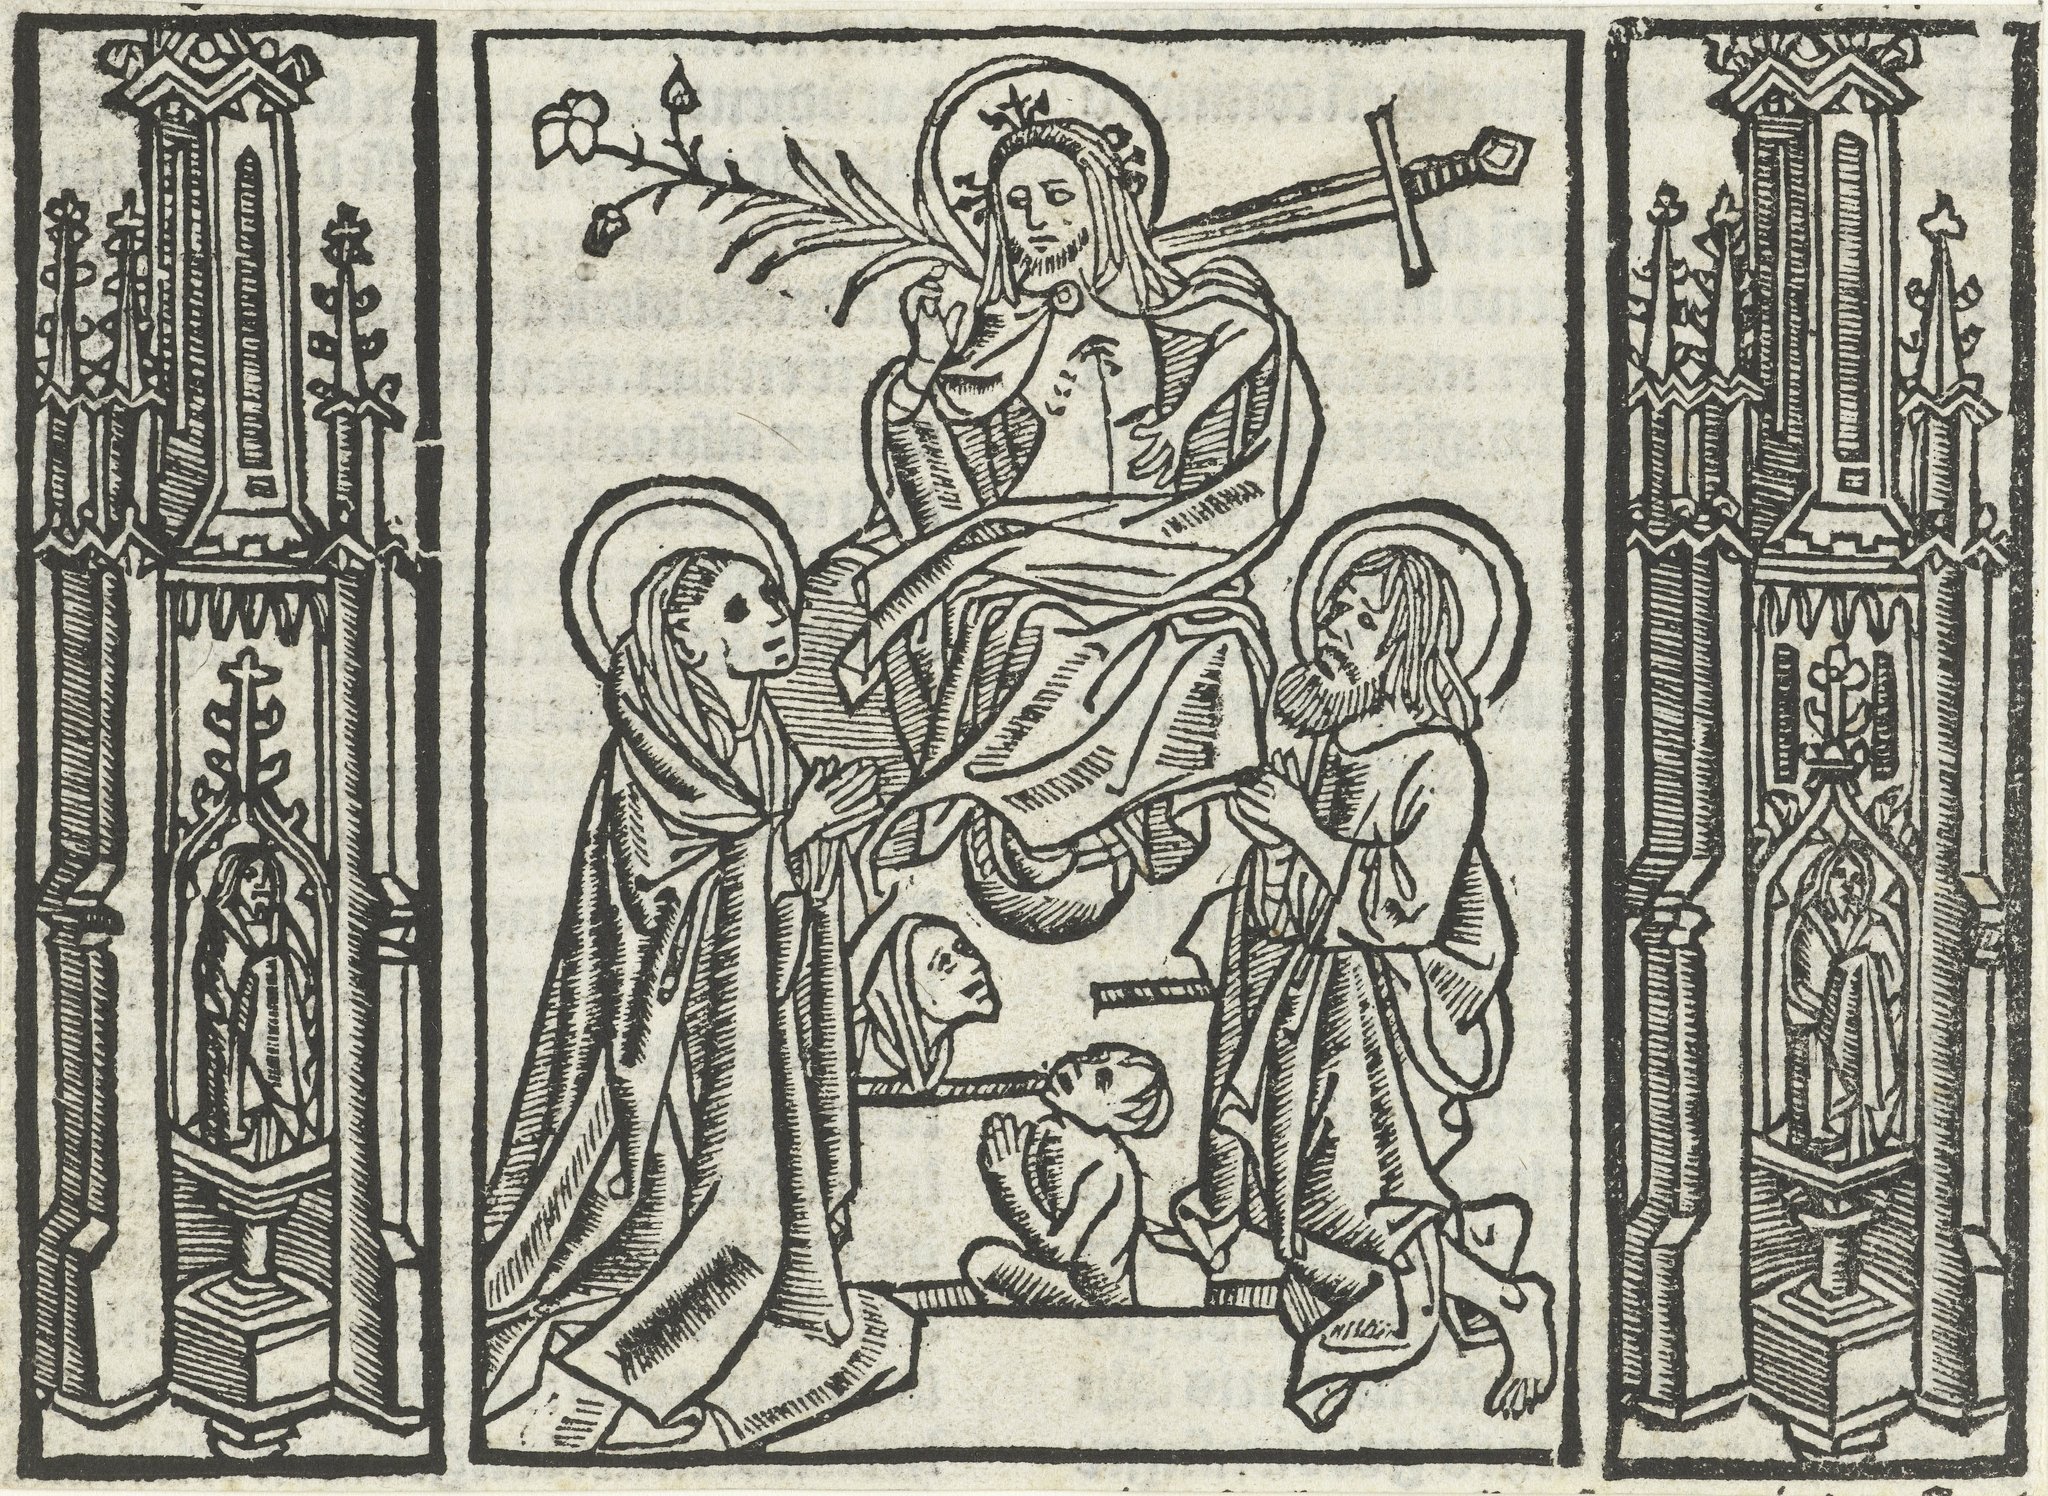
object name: print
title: Het laatste oordeel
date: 1480-1500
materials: paper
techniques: woodcut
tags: comprehensive representation of last judgement: christ (with sword and lily), often surrounded by elders and sometimes accompanied by mary and john the baptist, appears in the sky with trumpeting angels (and sometimes angels holding the instruments of the passion); after the resurrection of the dead the blessed are led to heaven by angels, and the damned are dragged into hell by devils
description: Eén blad van 113 uit Ludolphus de Saxonia, "Dit es dleué ons liefs heeren ihesu christi". Anonieme Nederlandse vertaling. Uitgegeven door Henrick Eckert van Homberch te Antwerpen in 1503. Botke, K. Deze 113 houtsneden, die meestal reeds in vroege Nederlandse boeken gebruikt zijn, worden toegeschreven aan de tweede Meester van Delft, de Meester van de Delbecq-Schreiber-passie en de Meester van de Virgo inter Virgines. In Conway (1884) en in "De gulden passer"(1951) zijn ook eerdere versies opgenomen. Botke, K.